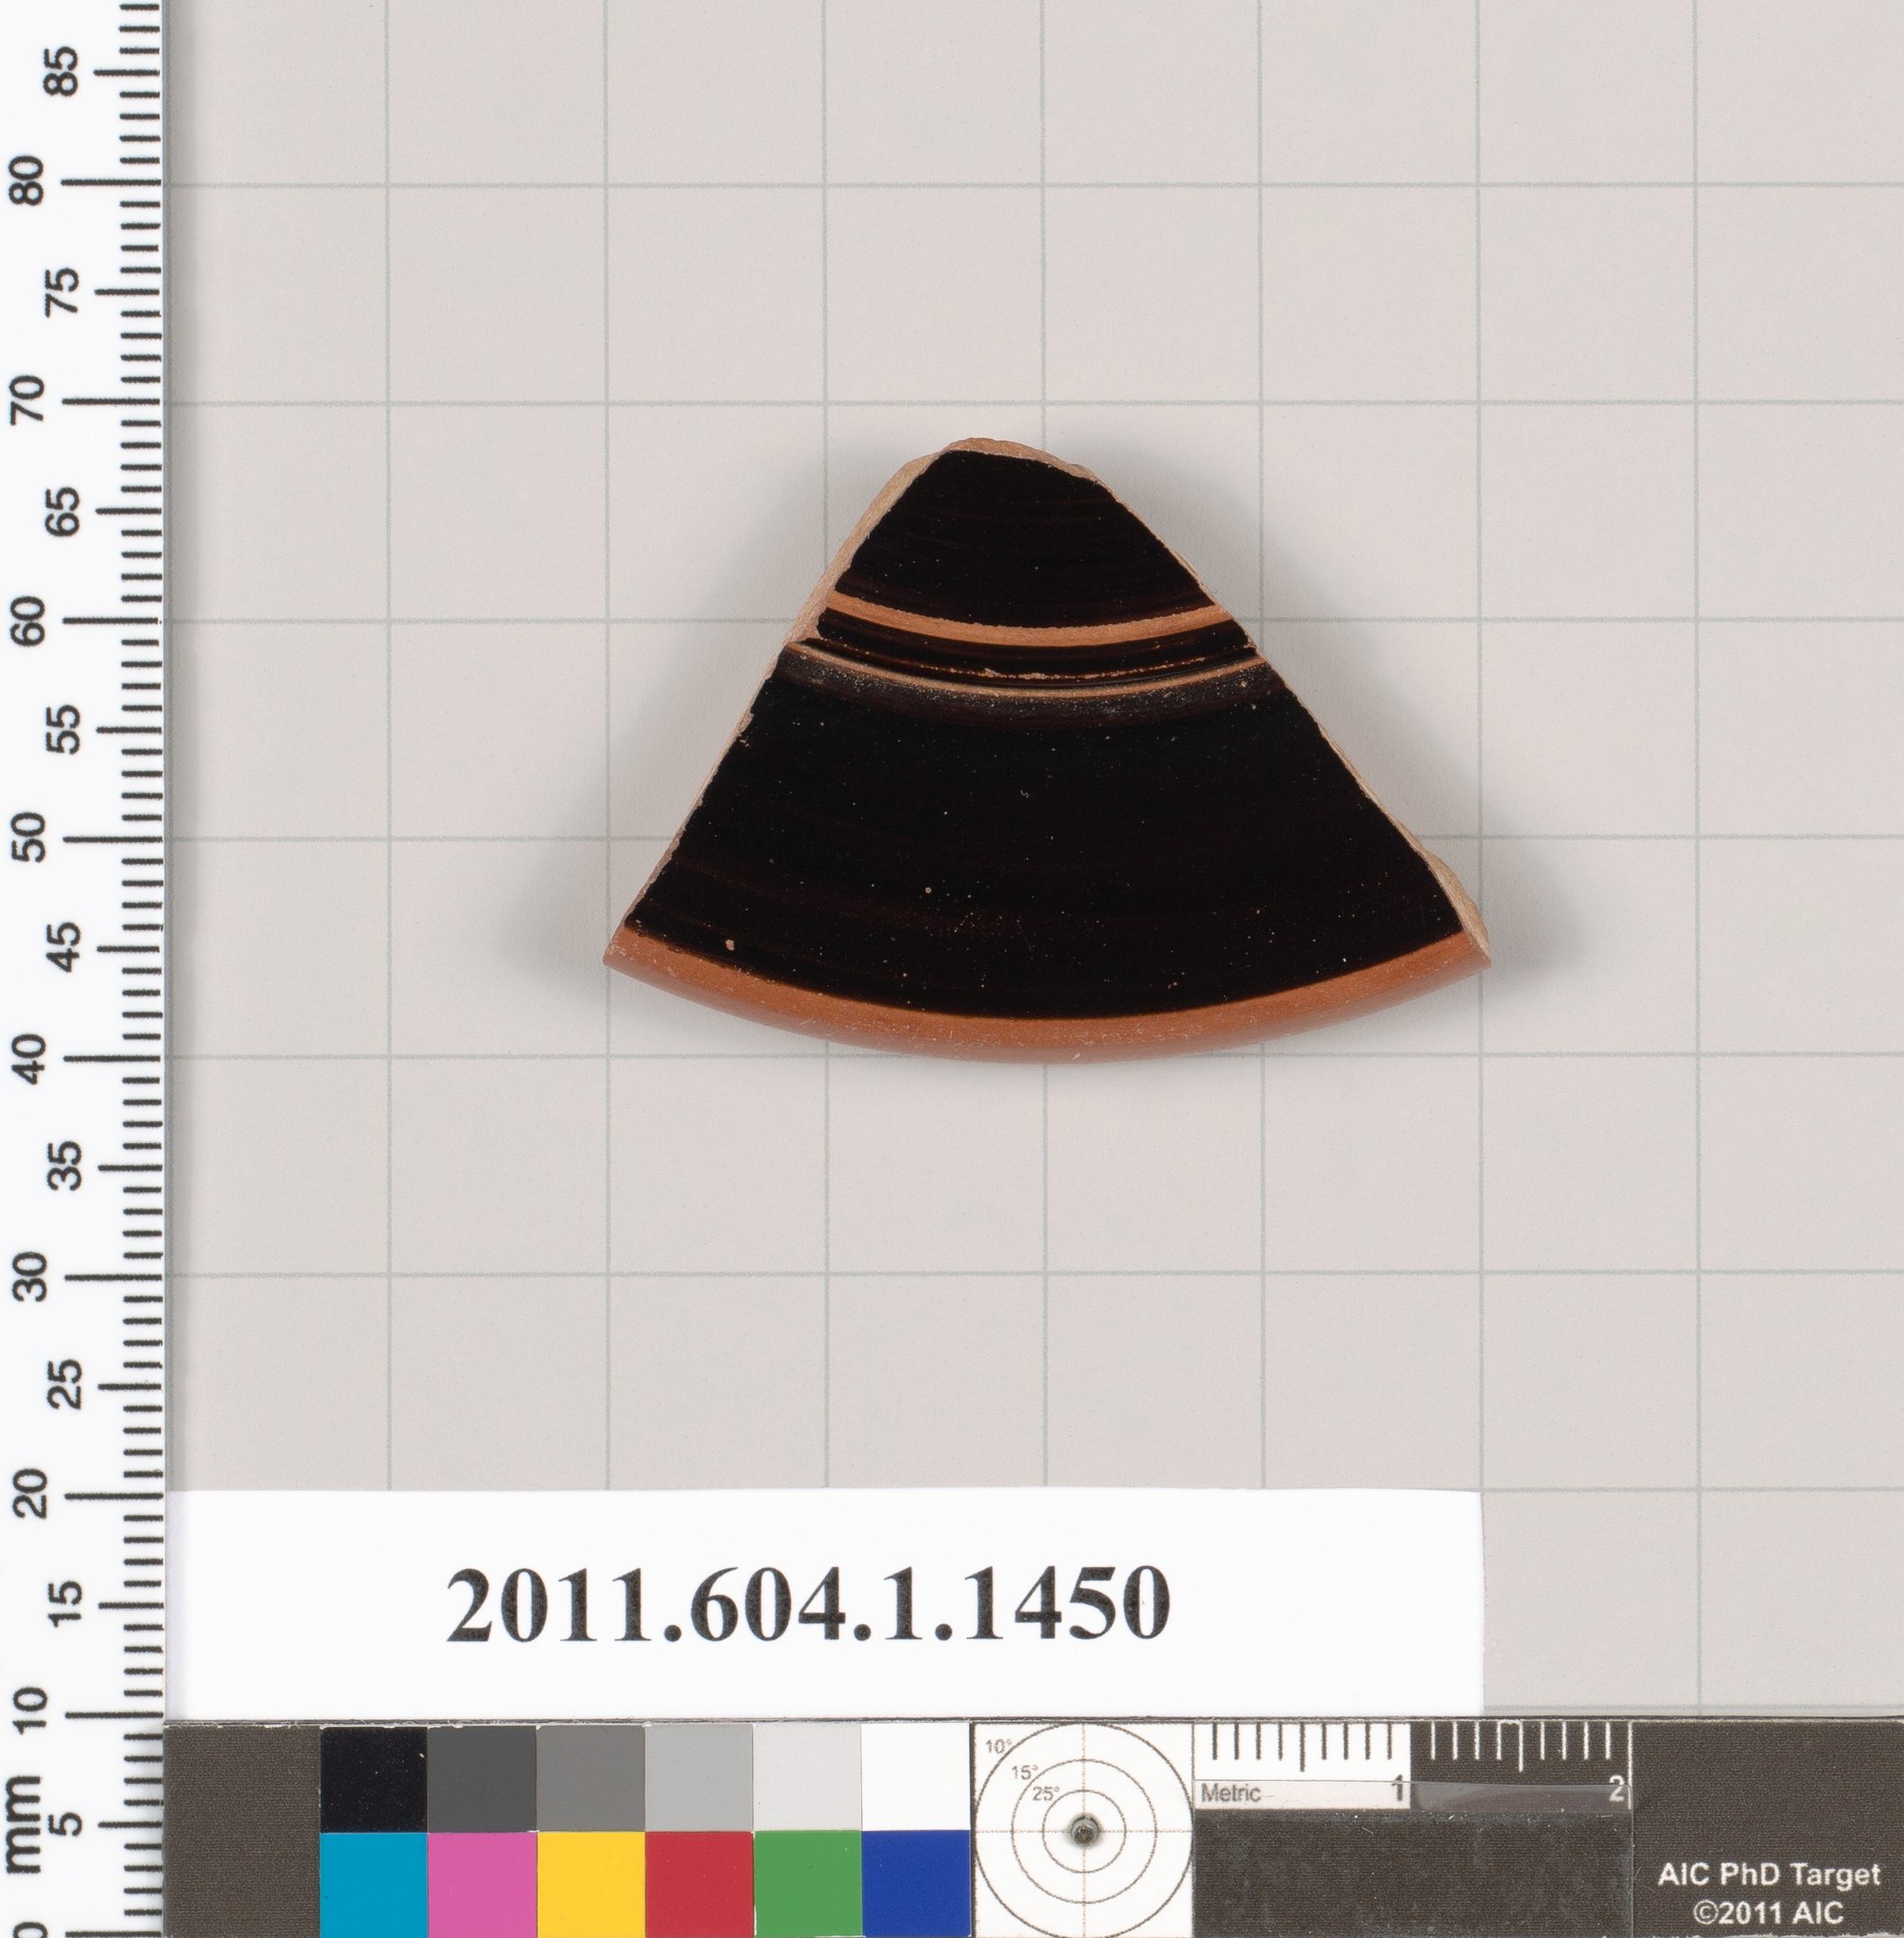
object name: kylix fragment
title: Terracotta fragment of a kylix (drinking cup)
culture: greek, attic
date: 500-401 BCE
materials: terracotta